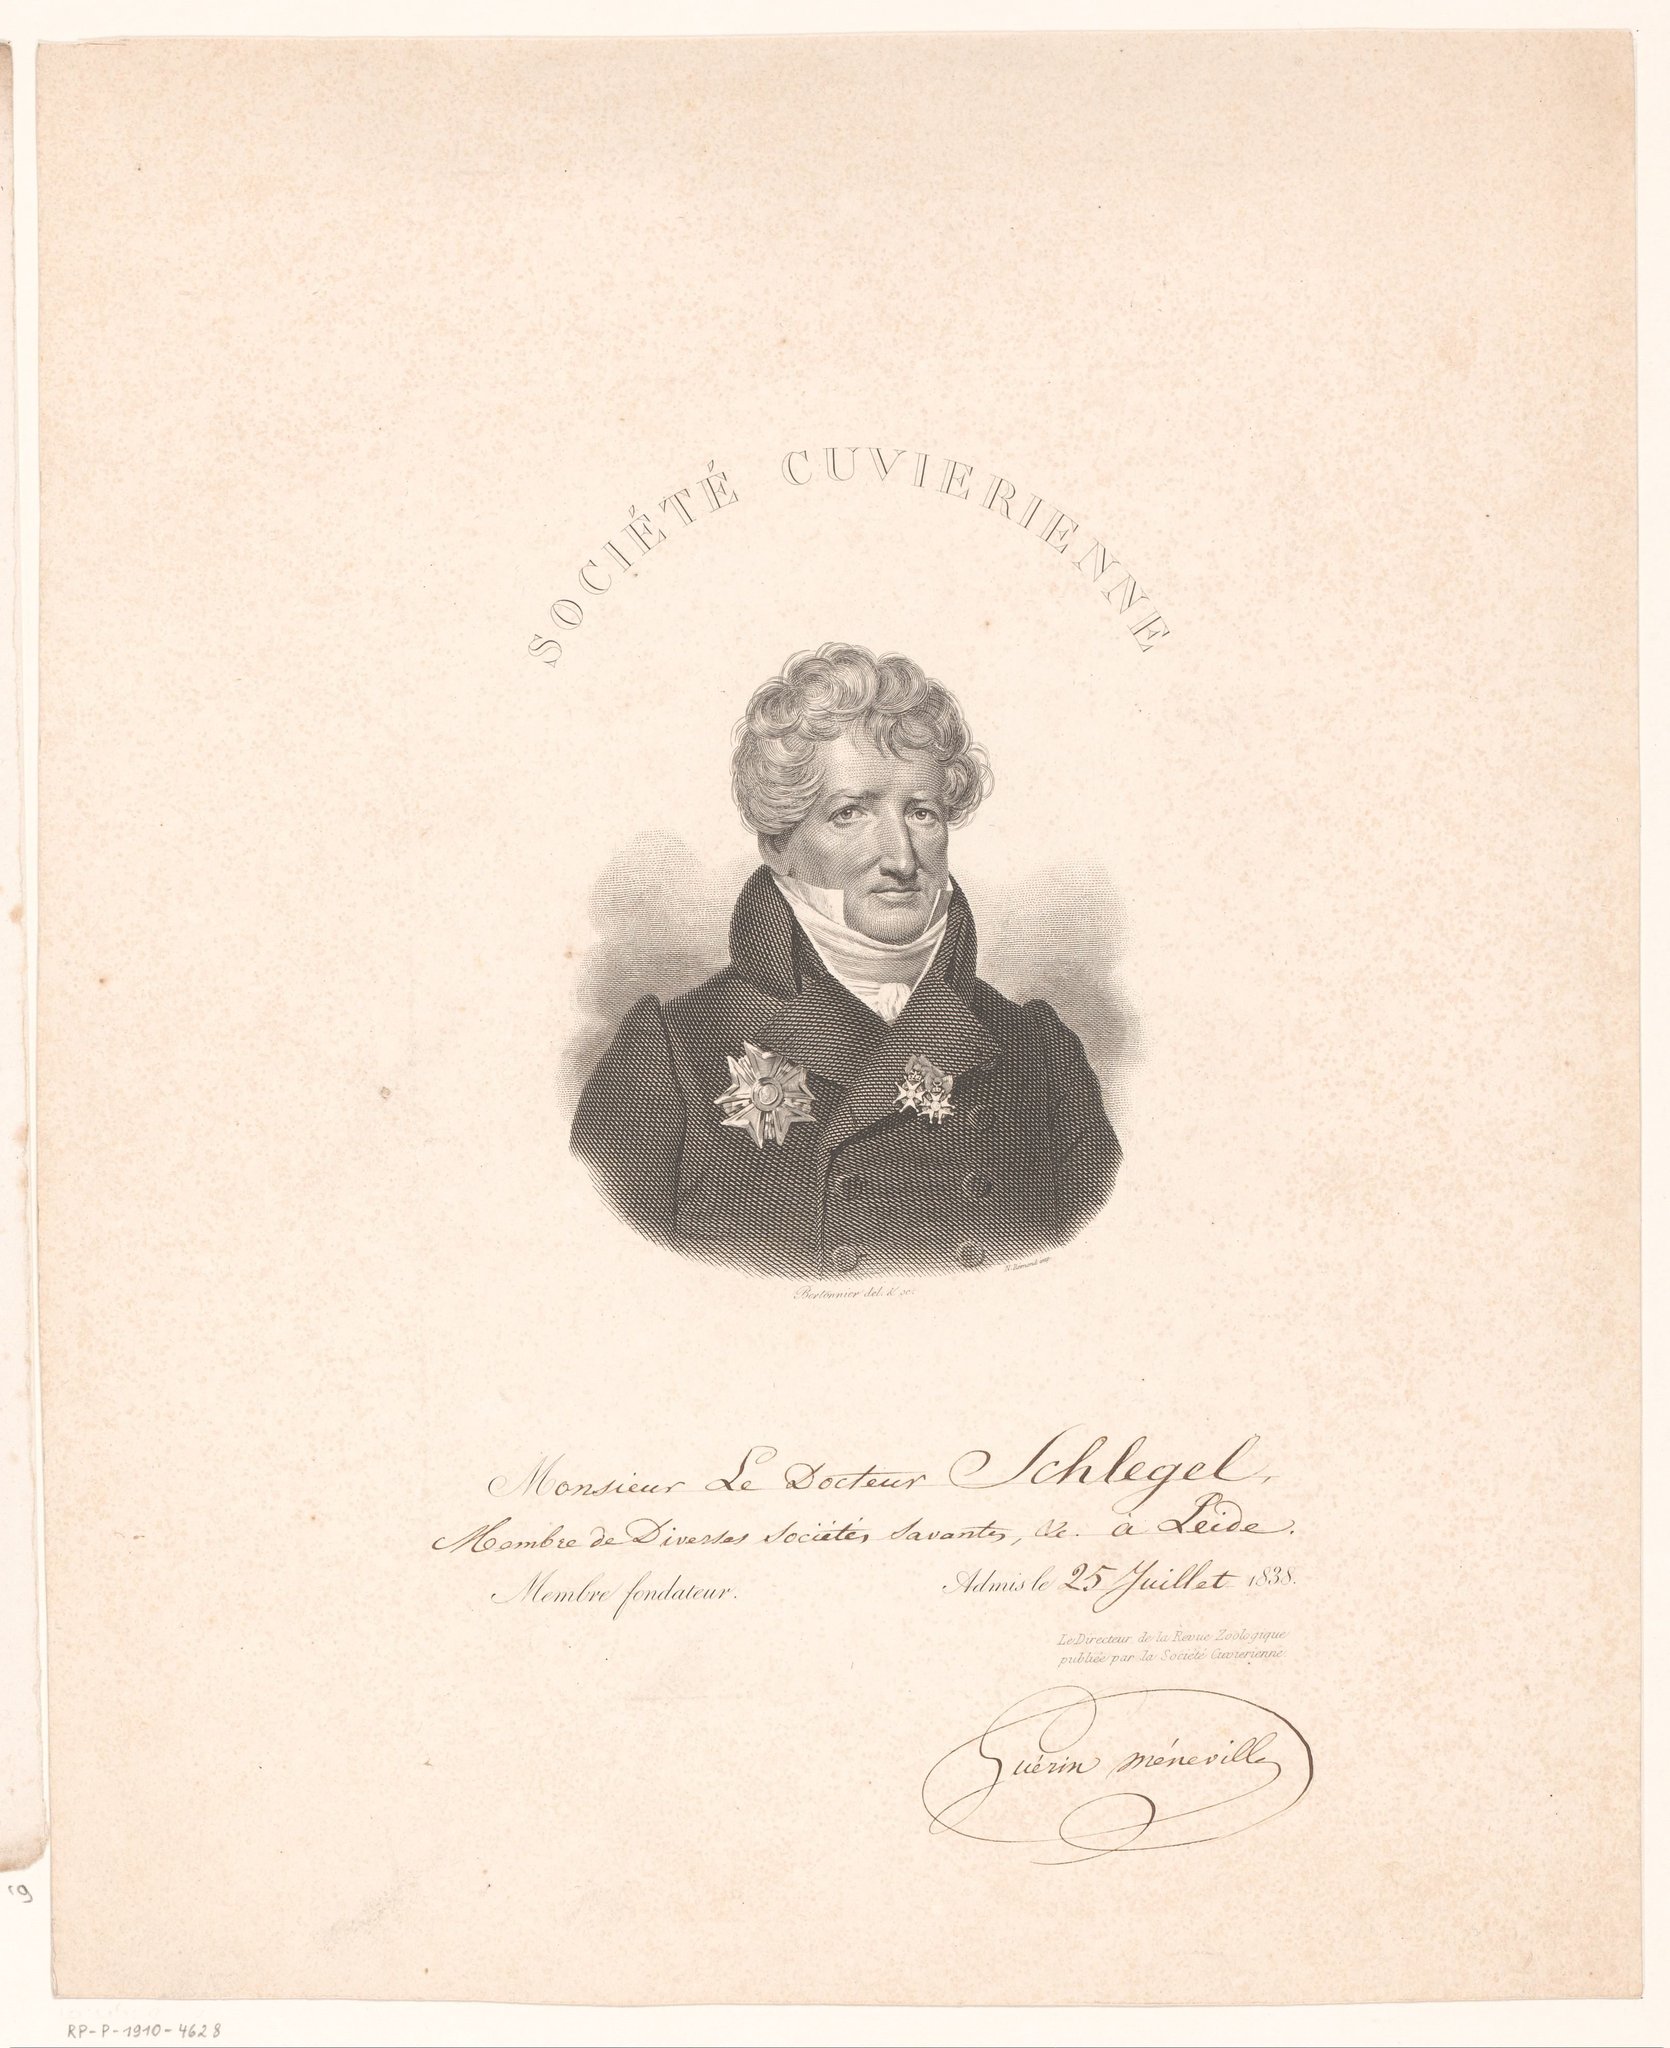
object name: print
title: Prent ter ere van het lidmaatschap van dokter Schlegel in de Société Cuvierienne met portret van Georges Cuvier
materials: paper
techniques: engraving, etching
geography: france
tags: paris, leiden, hermann schlegel, historical persons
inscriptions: signature: ‘Guérin méneville’, collector's mark: Lugt 2228